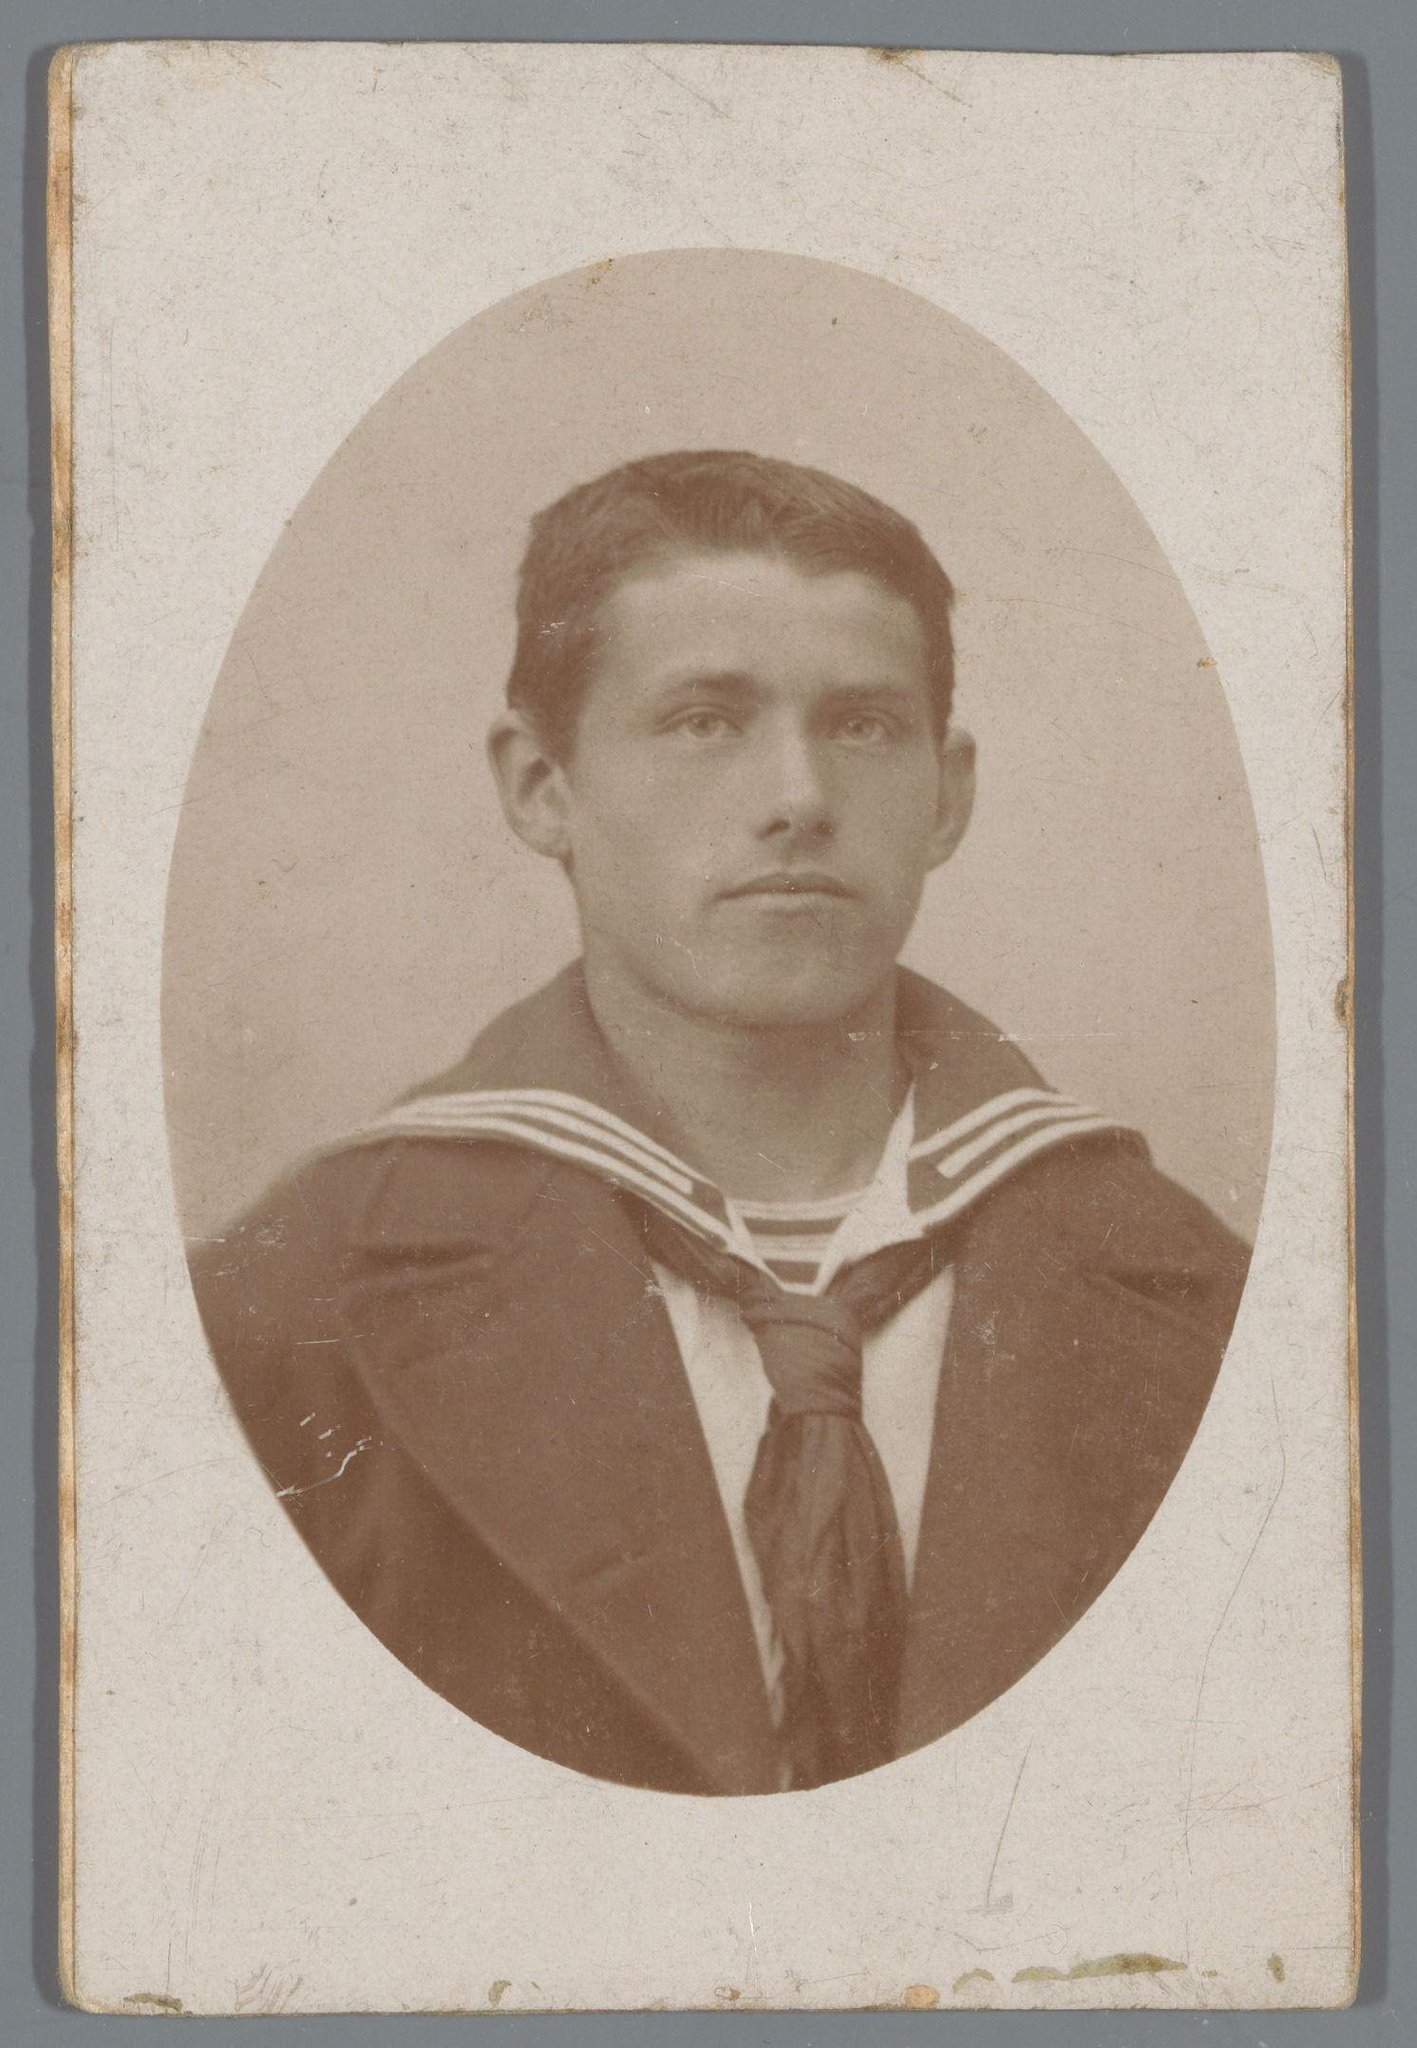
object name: carte de visite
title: Portret van een onbekende man in matrozenpak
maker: Anonymous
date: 1880-1914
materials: paper, cardboard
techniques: collodion silver print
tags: sailor, anonymous historical person portrayed